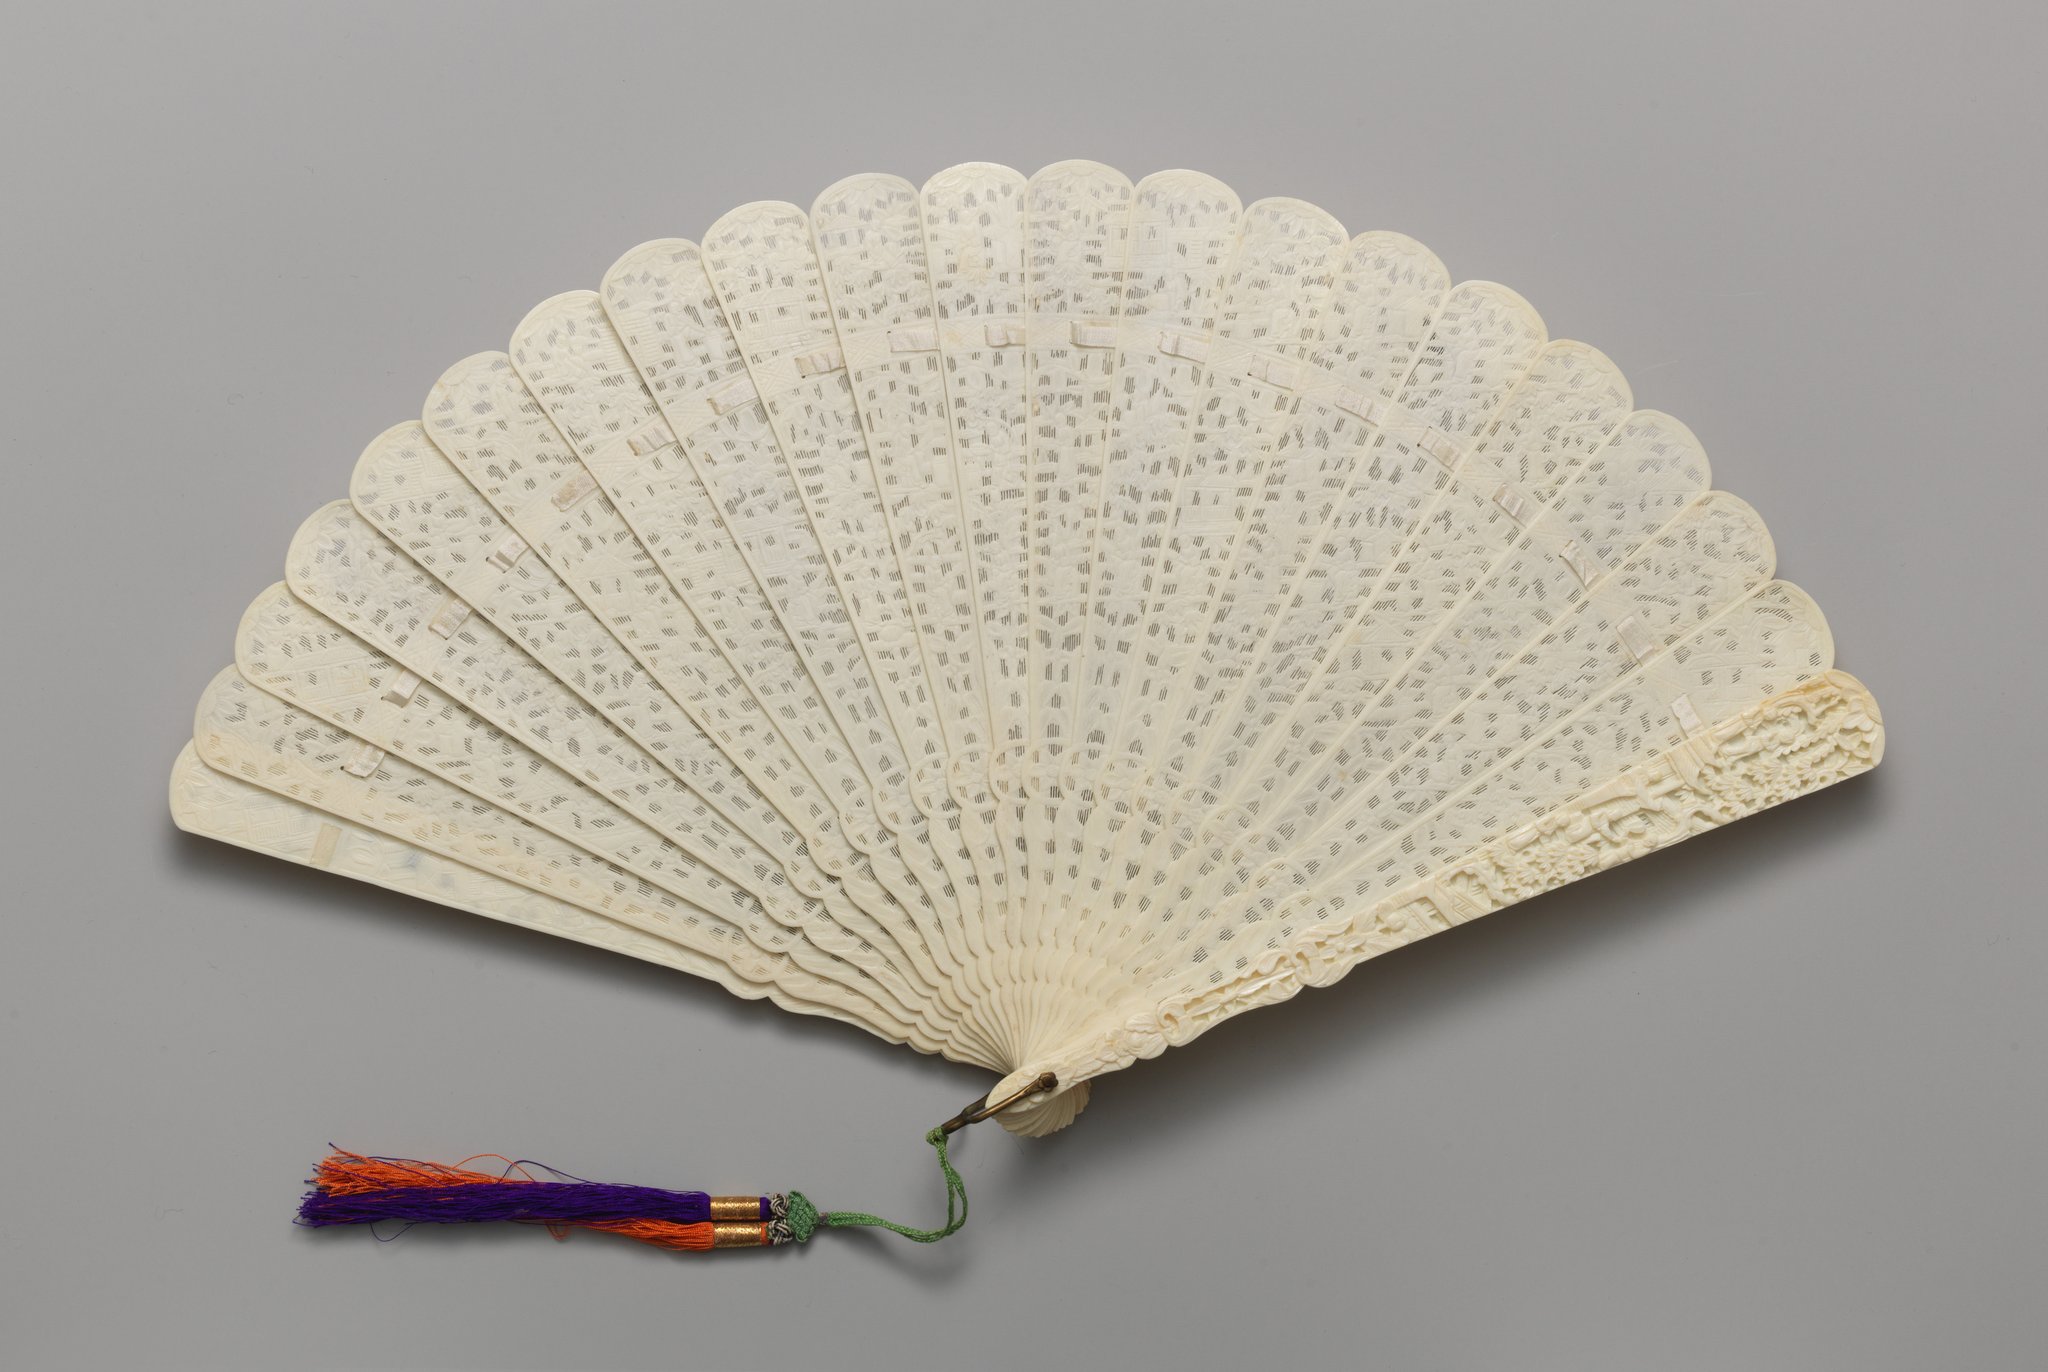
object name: fan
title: Brisé Fan, with Simple Carved Patterning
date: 1801-1900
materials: ivory